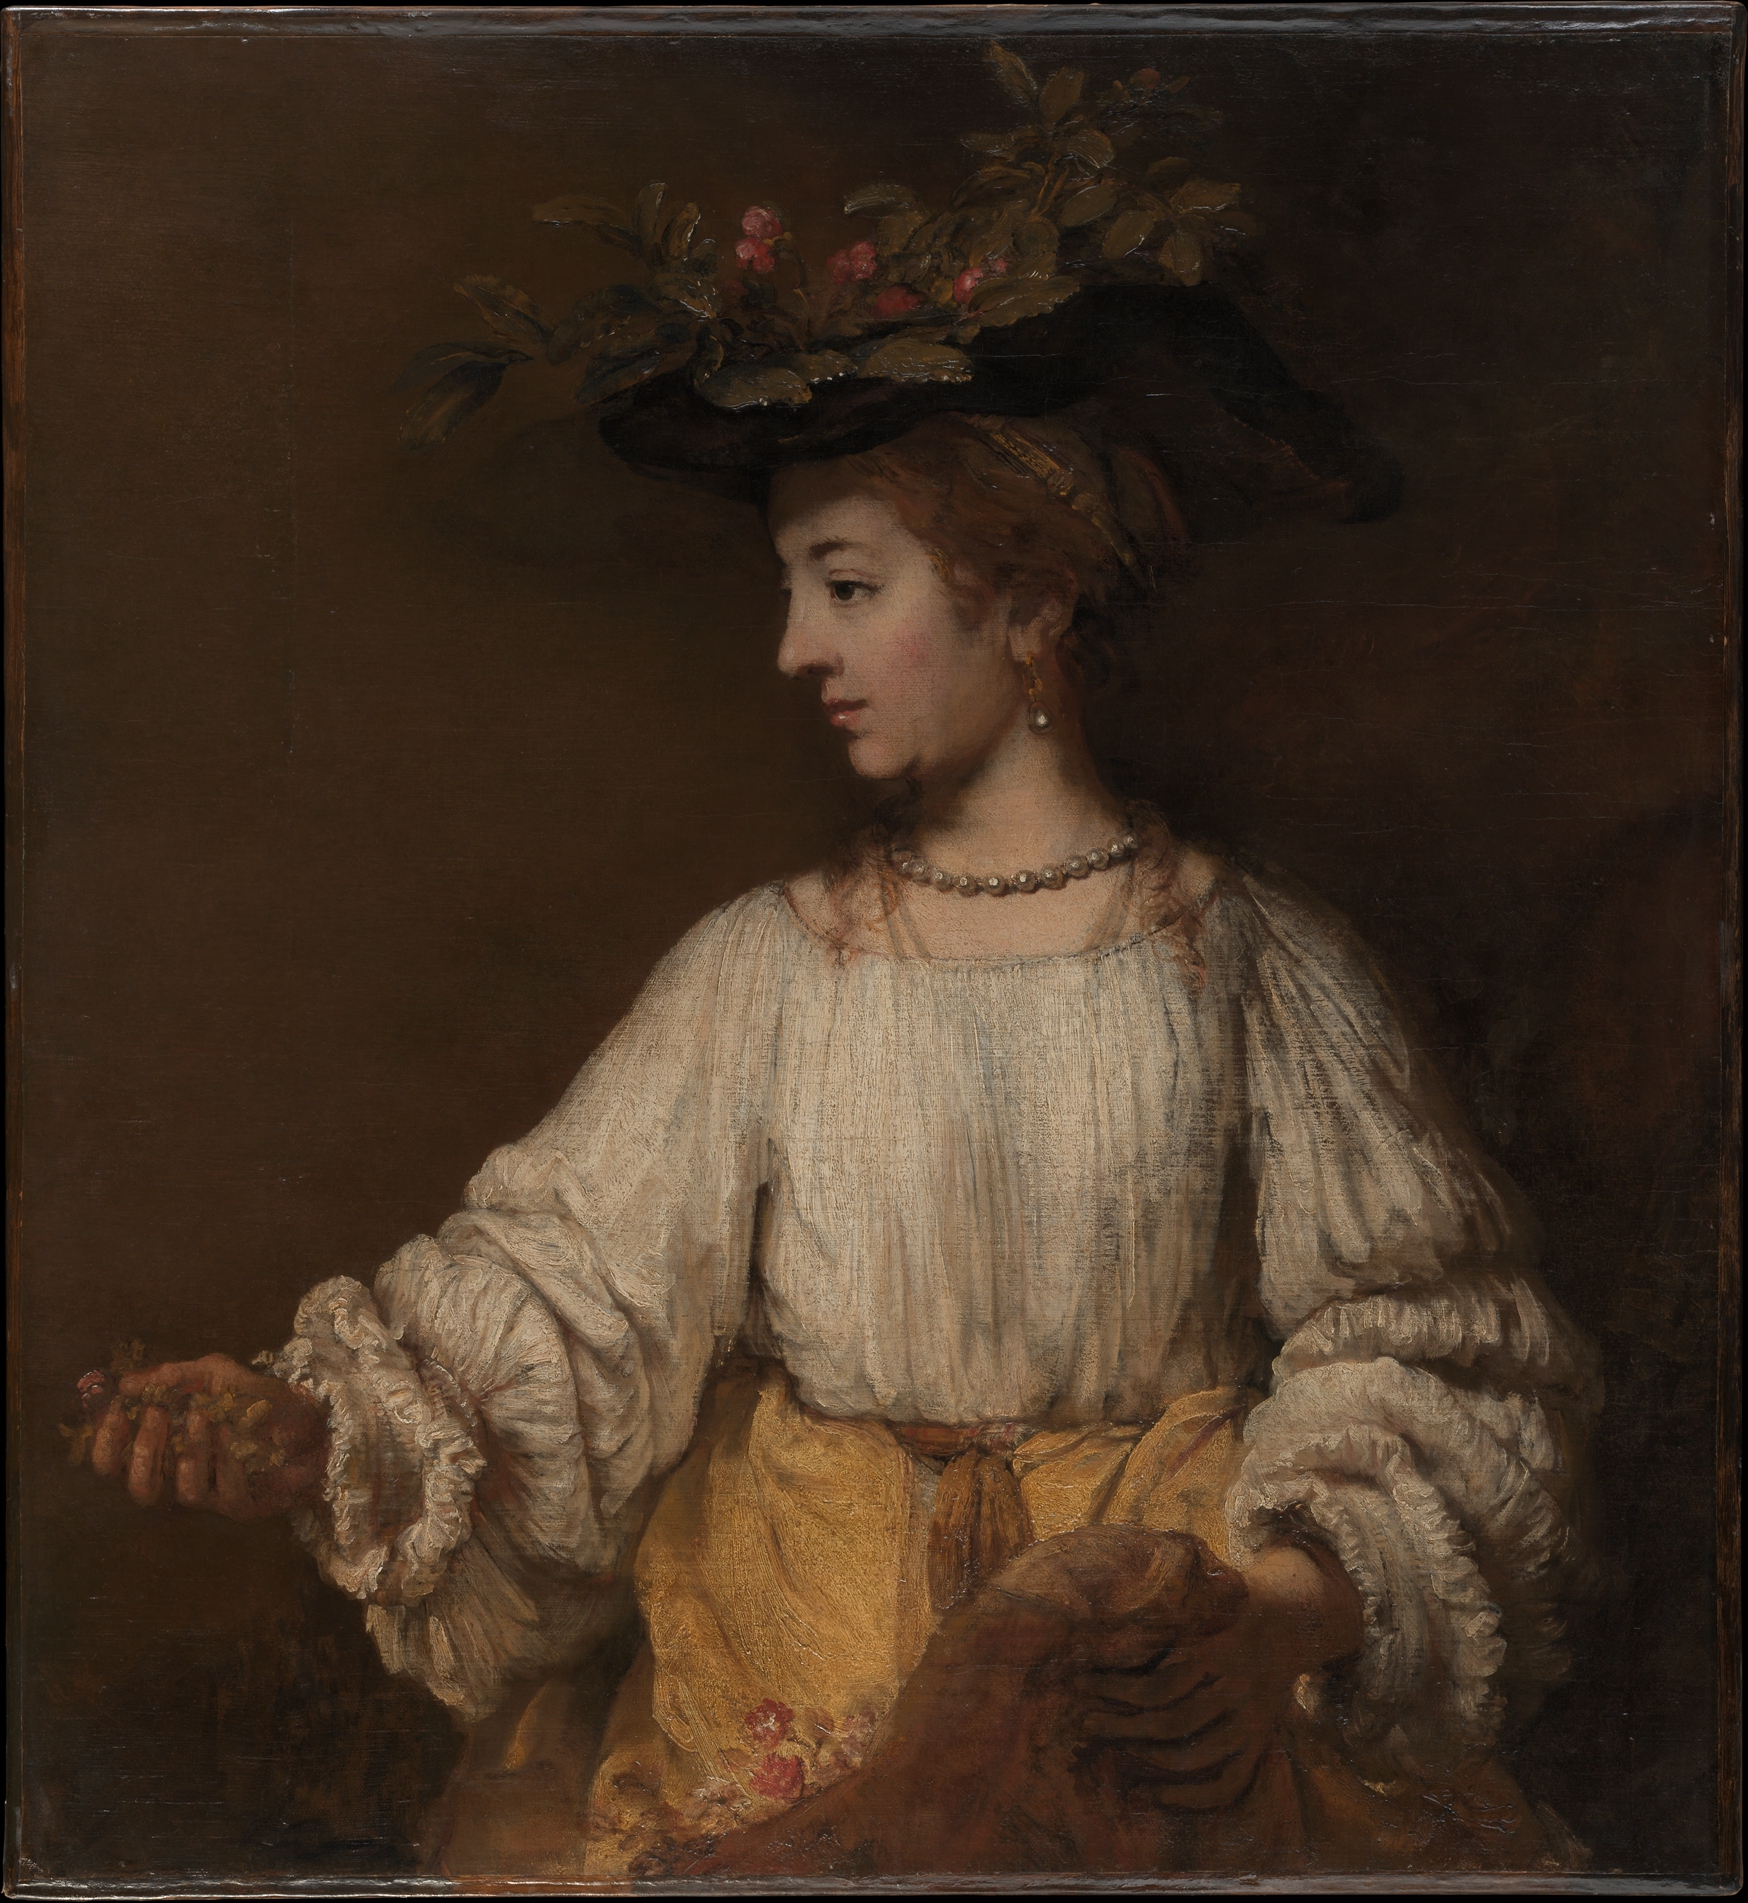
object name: painting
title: Flora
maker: rembrandt van rijn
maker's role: artist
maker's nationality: dutch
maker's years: 1606-1669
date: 1654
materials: canvas, oil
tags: profiles,women,flowers